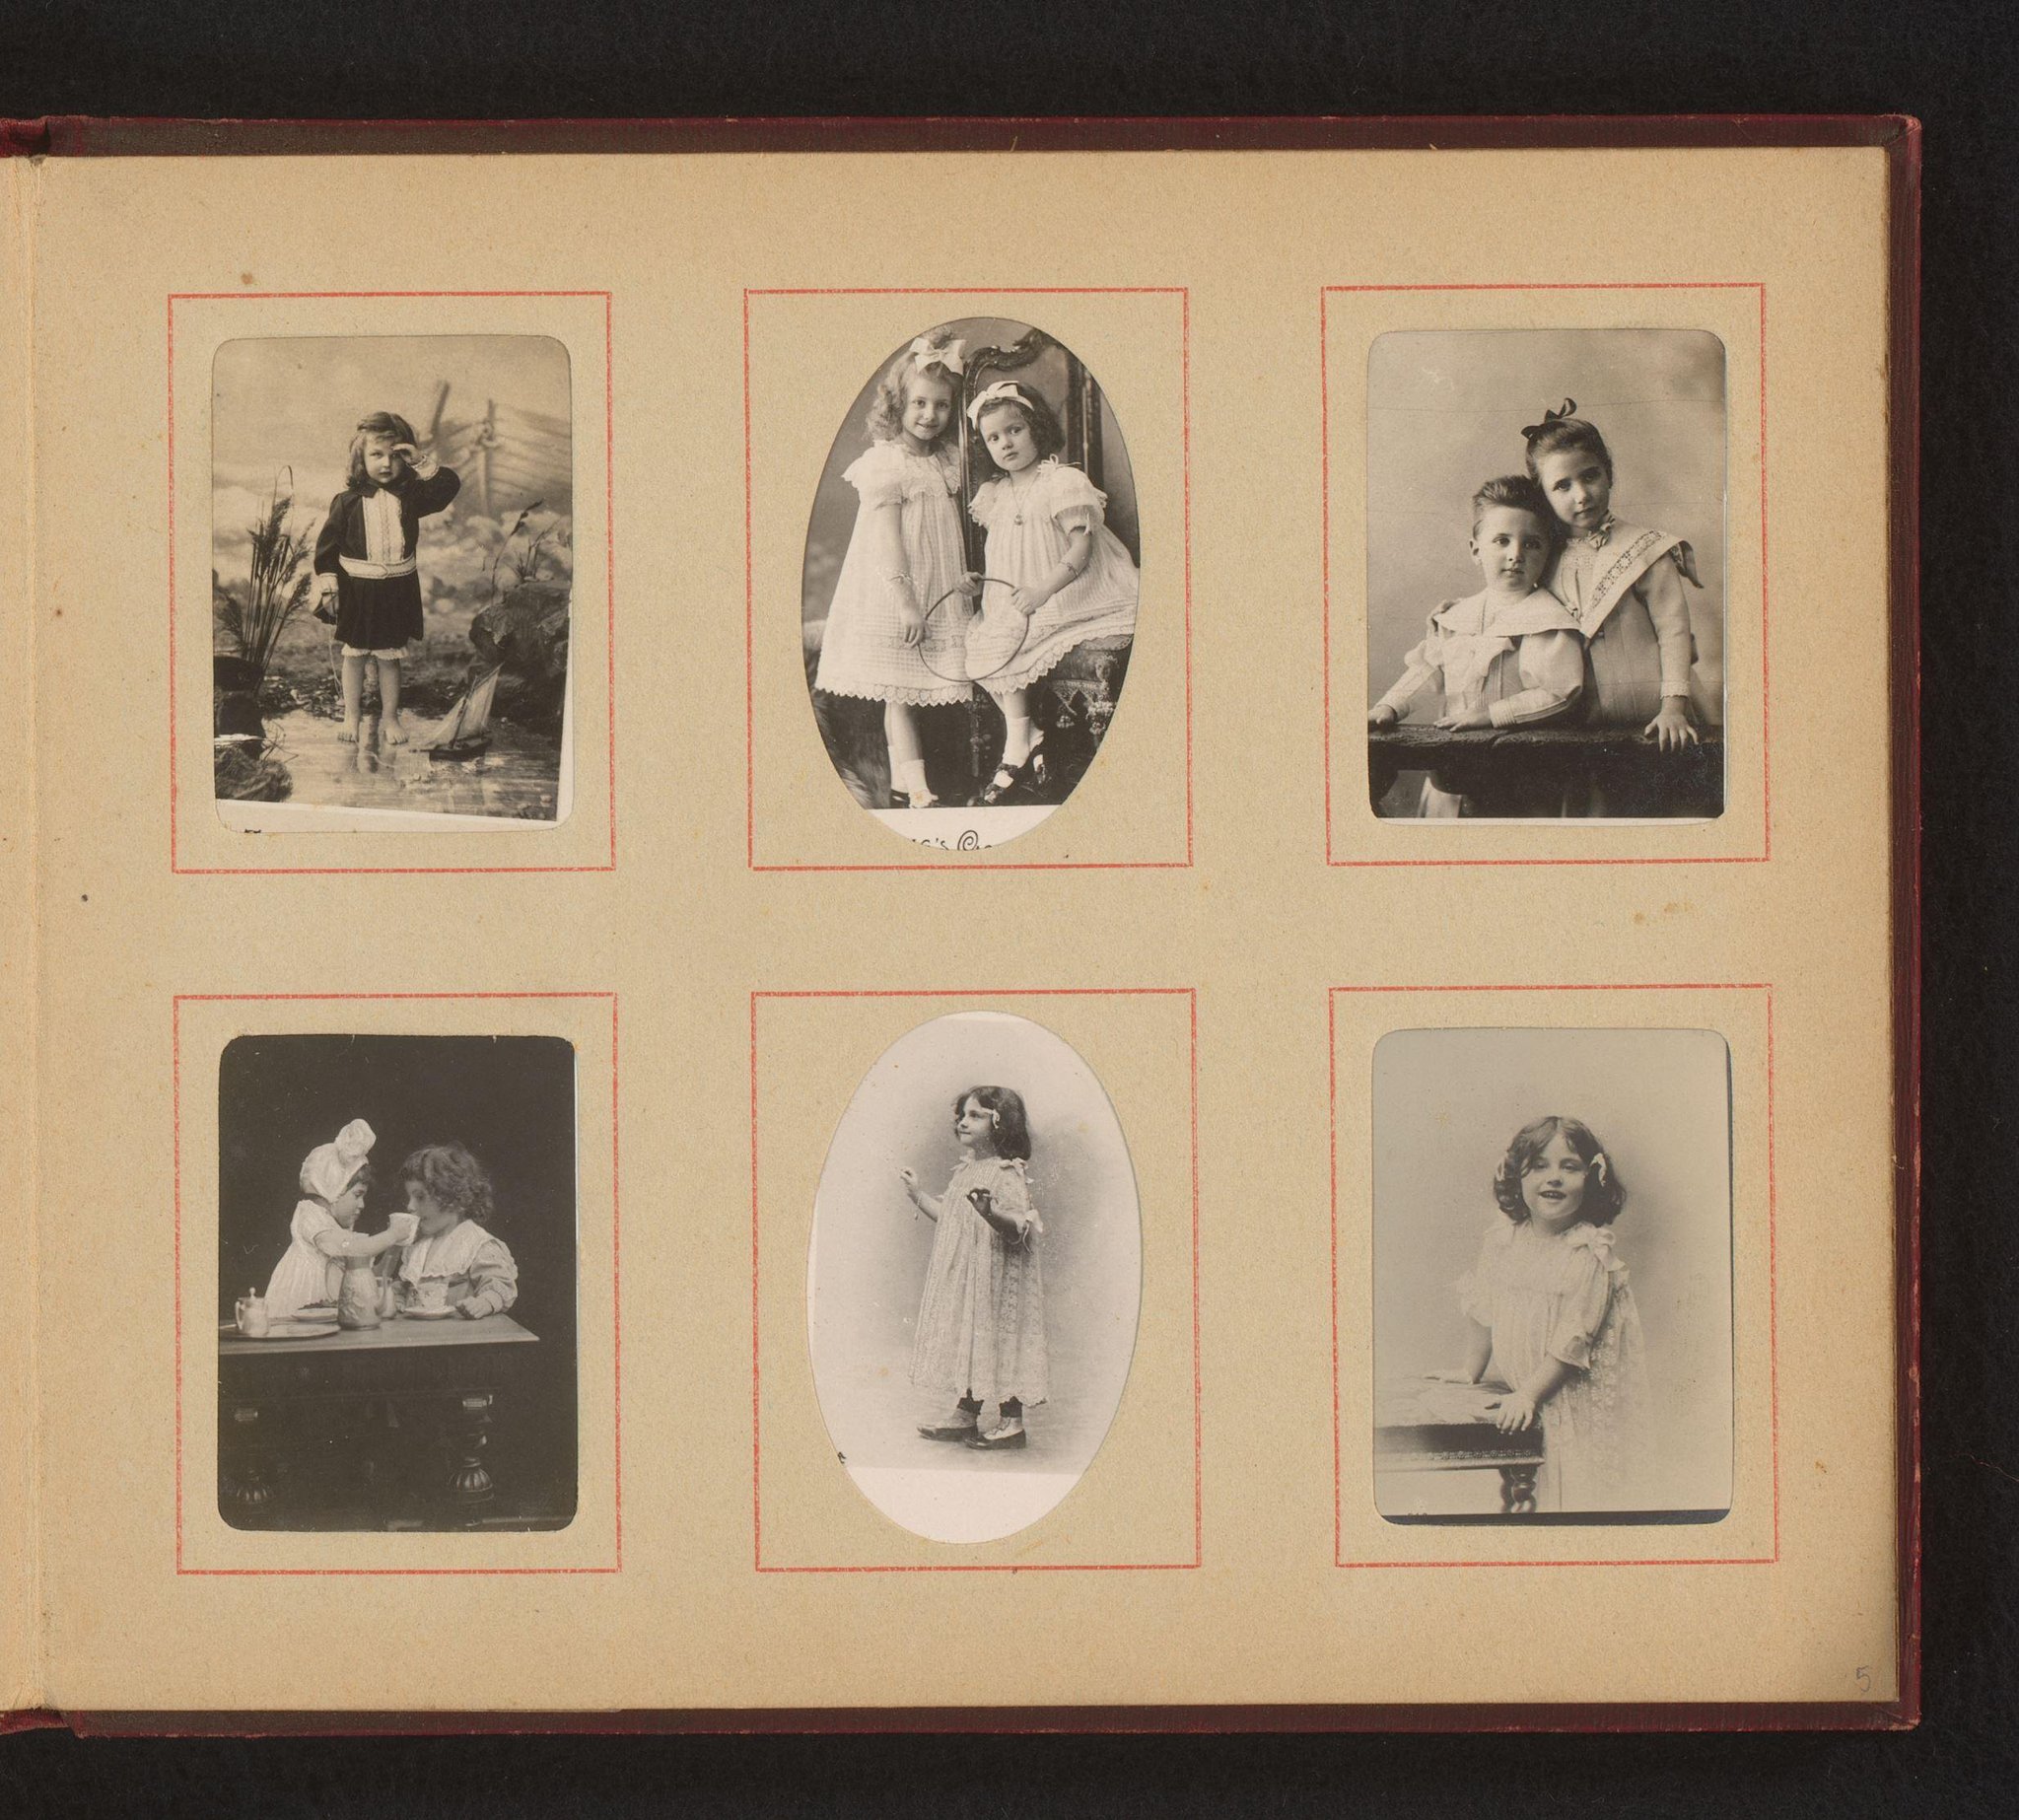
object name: album leaf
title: Kinderportretten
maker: Anonymous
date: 1880-1920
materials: photographic support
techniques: gelatin silver print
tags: historical persons, girl (child between toddler and youth), trade games, imitative games, imitating adults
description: Zes portretten van meisjes. Deze pagina maakt deel uit van een album.